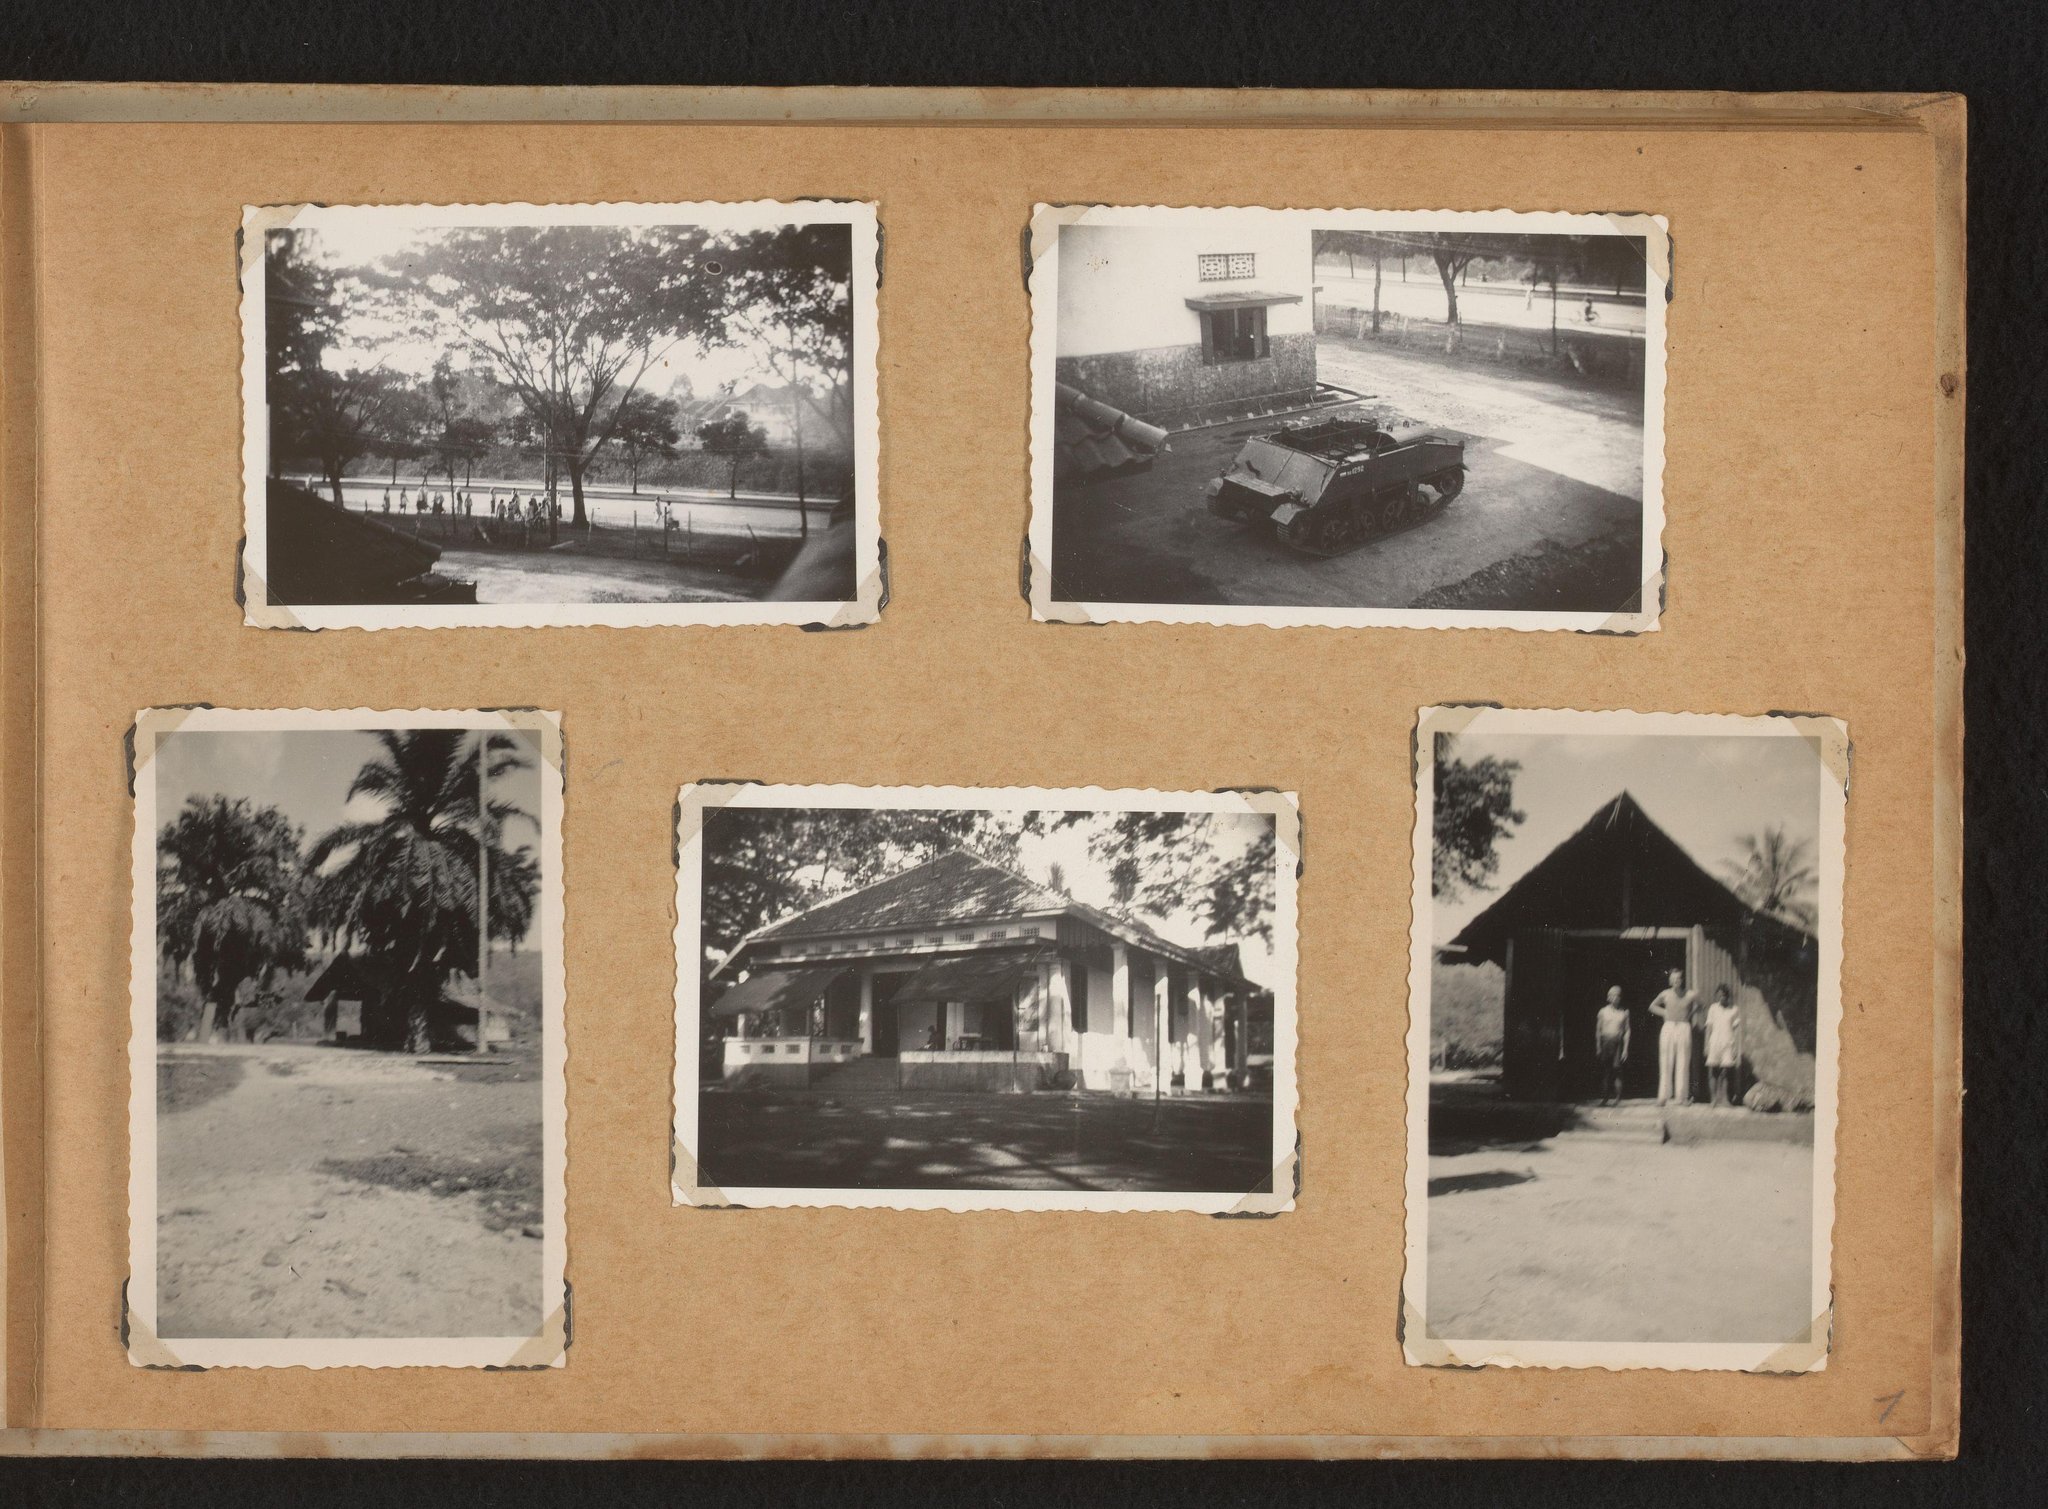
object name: album leaf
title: Onderkomen en pantservoertuig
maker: Anonymous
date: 1948-1949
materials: paper, photographic support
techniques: gelatin silver print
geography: dutch east indies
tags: modern forms of military vehicles, street, dutch east indies, the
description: Albumblad met vijf foto's met diverse onderwerpen: voorbijgangers op straat, een pantservoertuig en gebouwen. Onderdeel van het fotoalbum 'Ter herinnering aan mijn diensttijd overzee' 1948-1949.